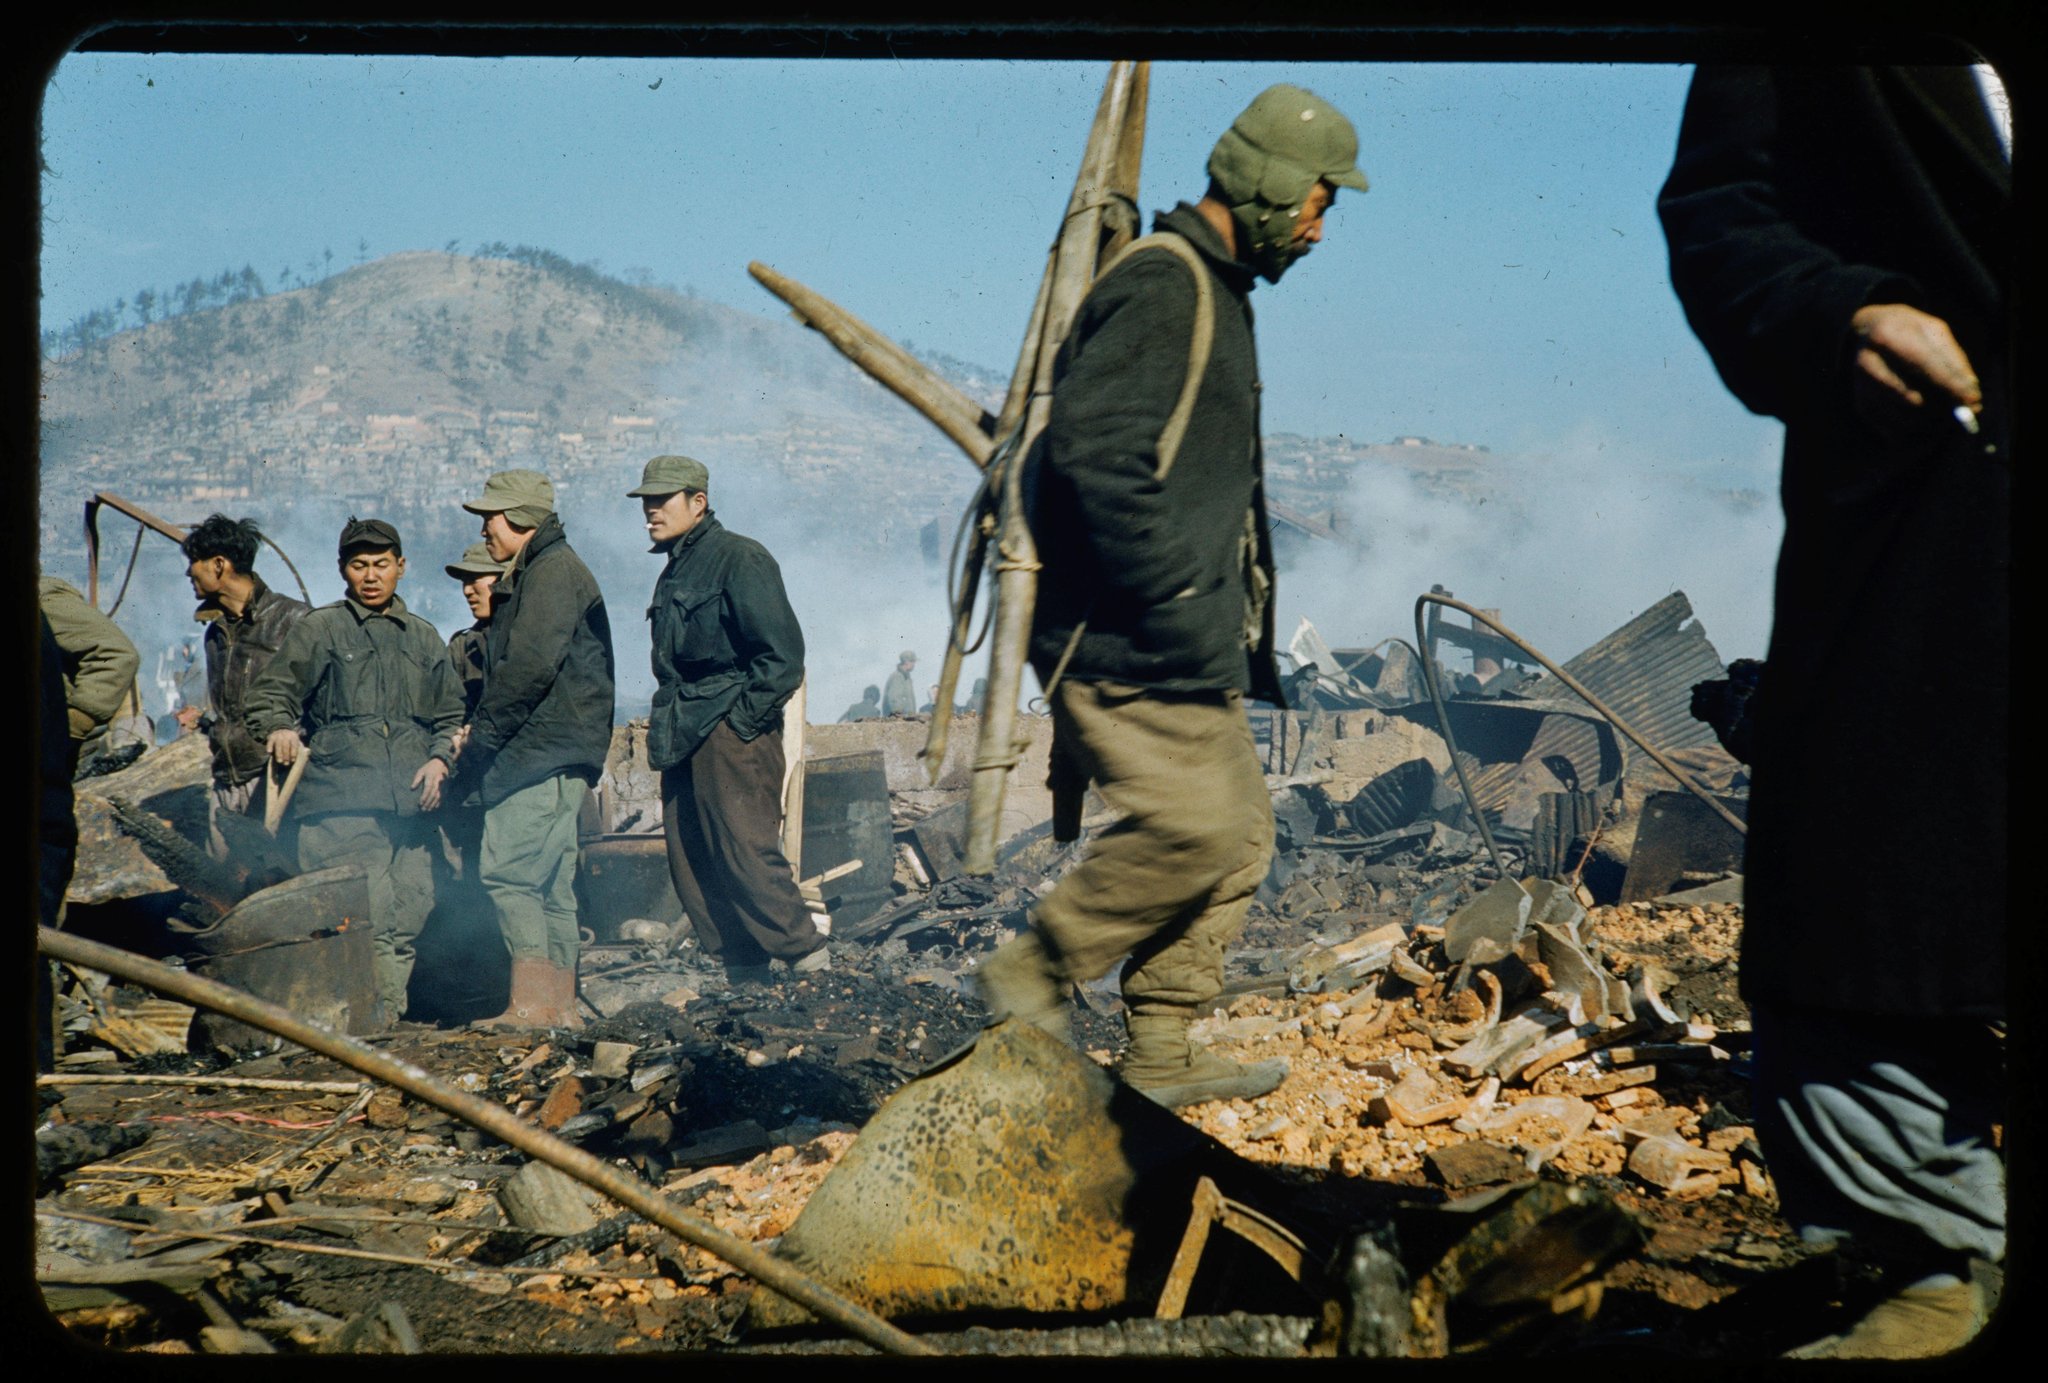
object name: color slide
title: Oorlog in Korea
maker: david ketel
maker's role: diplomaat, sinoloog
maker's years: 1913-2008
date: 1951-1953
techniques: slide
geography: korea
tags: united nations